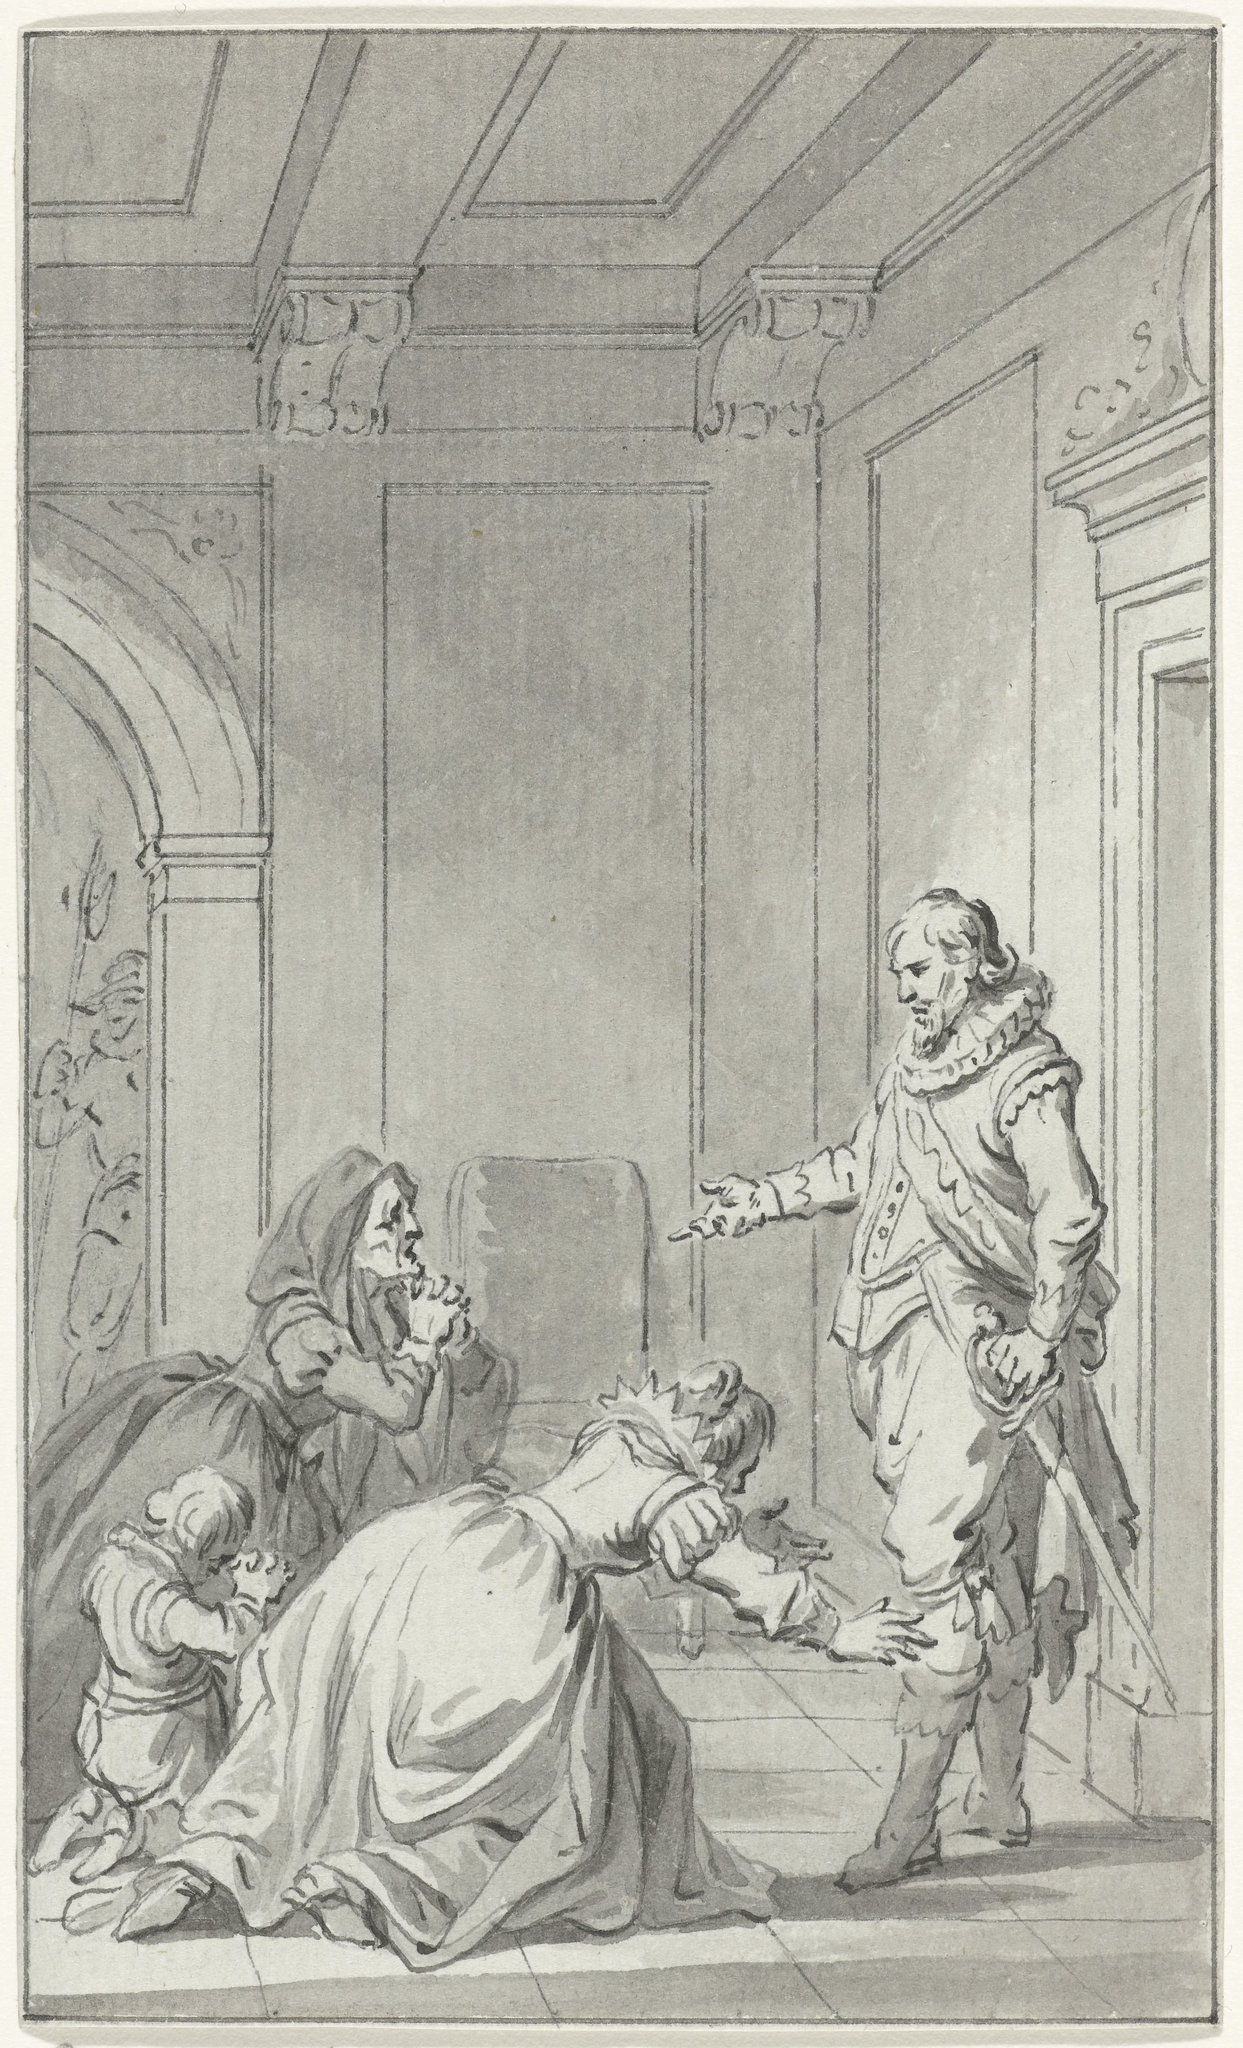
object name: drawing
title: Twee vrouwen en een kind, geknield smekend voor een heer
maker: jacobus buys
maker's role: draughtsman, print maker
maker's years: 1724-1801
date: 1734-1801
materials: ink, paper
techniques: brush, pen